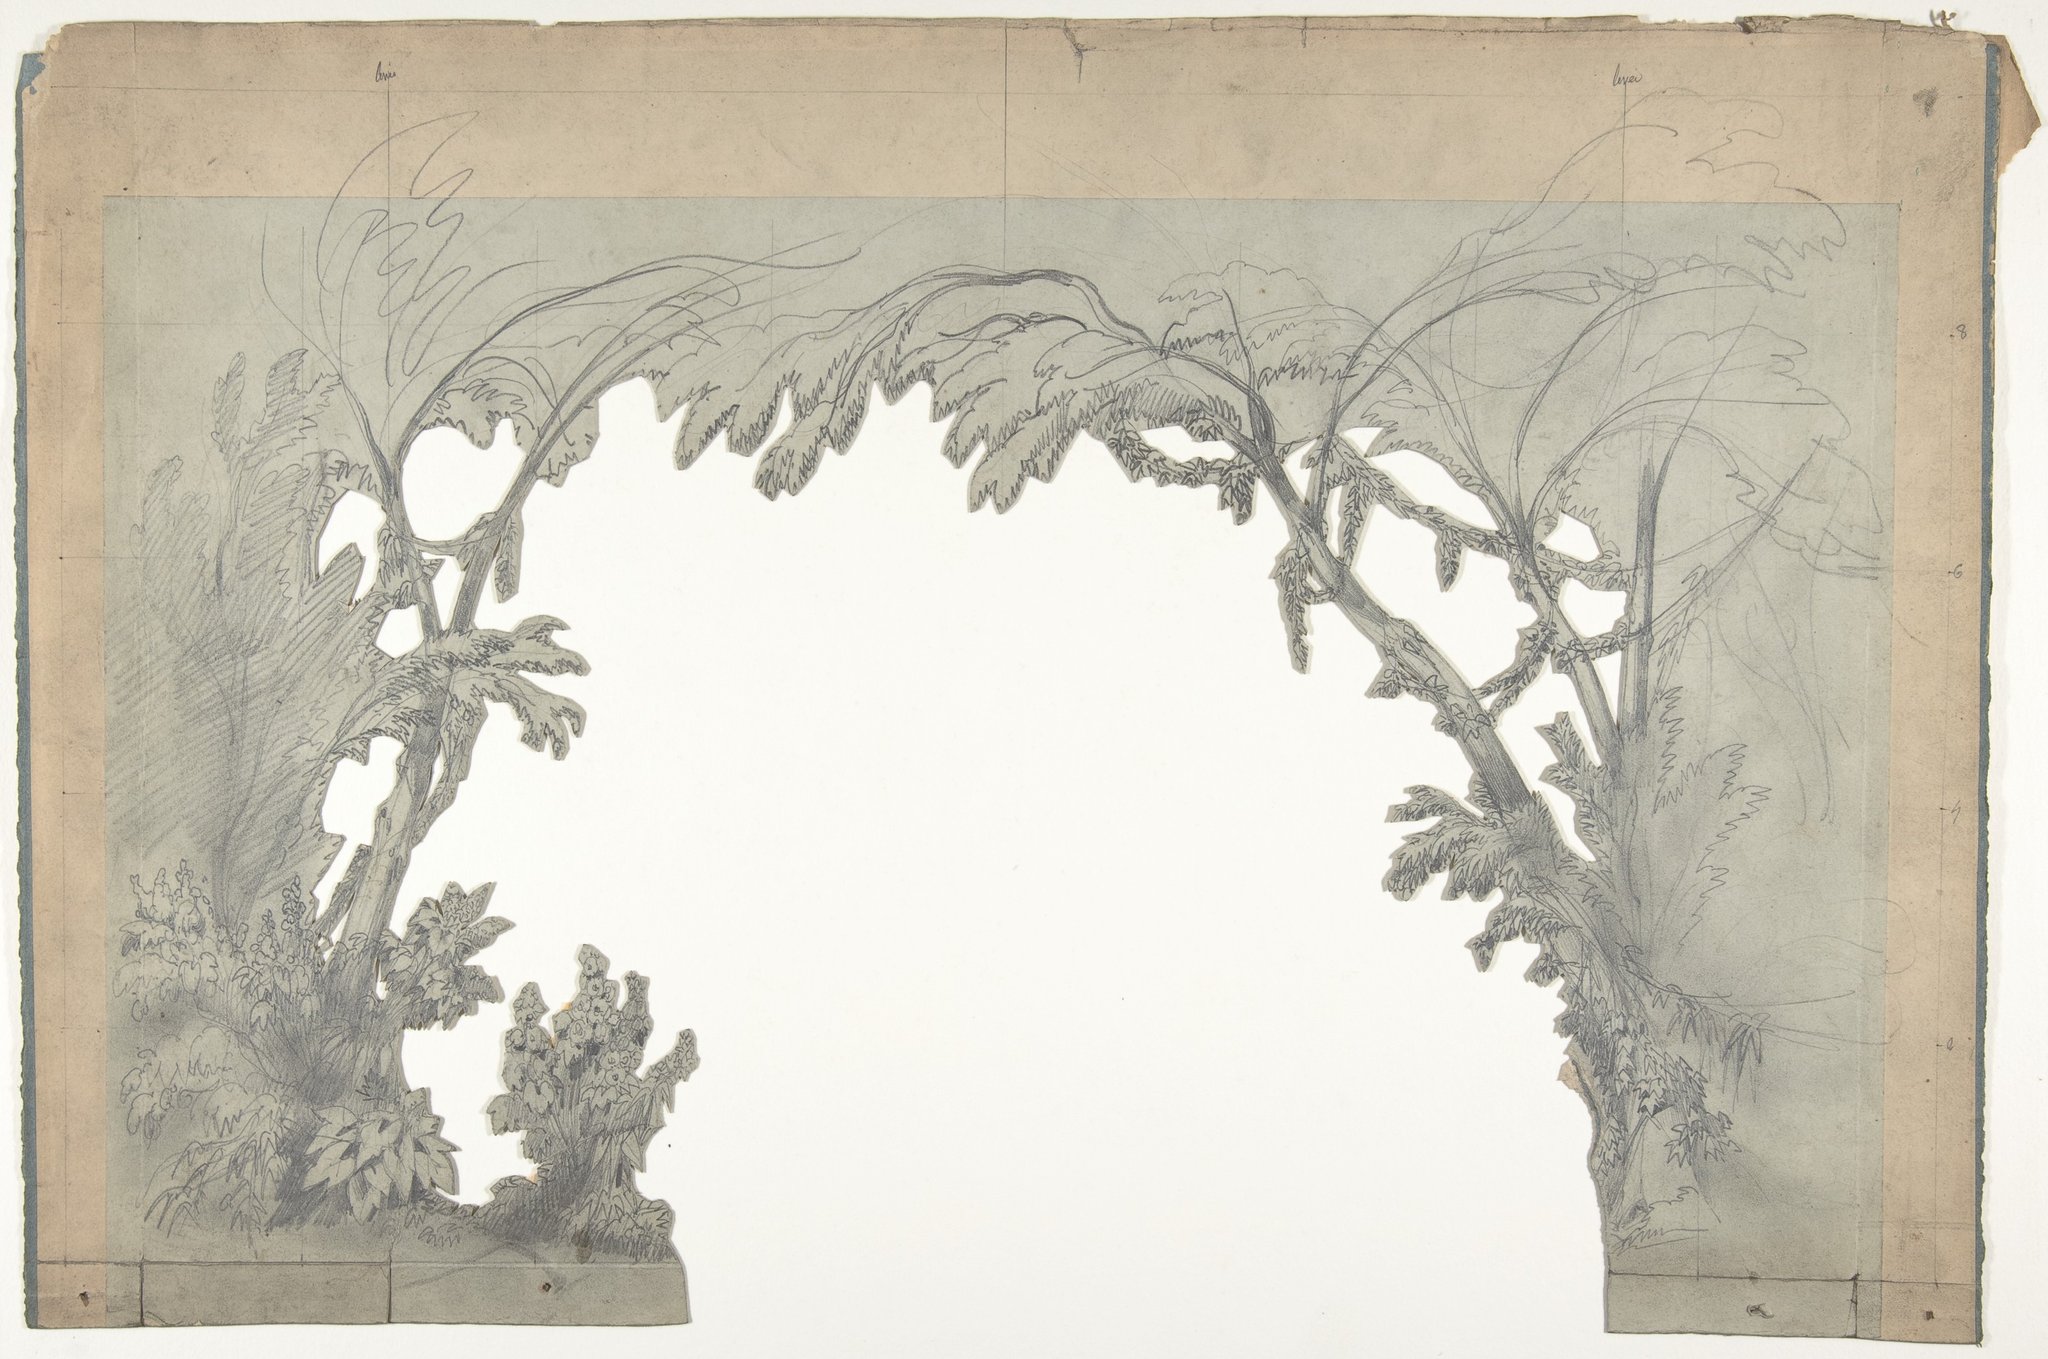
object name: drawing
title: Design for a Stage Set at the Opéra, Paris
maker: eugène cicéri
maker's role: artist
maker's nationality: french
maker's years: 1813-1890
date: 1830-1890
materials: graphite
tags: trees,stage design